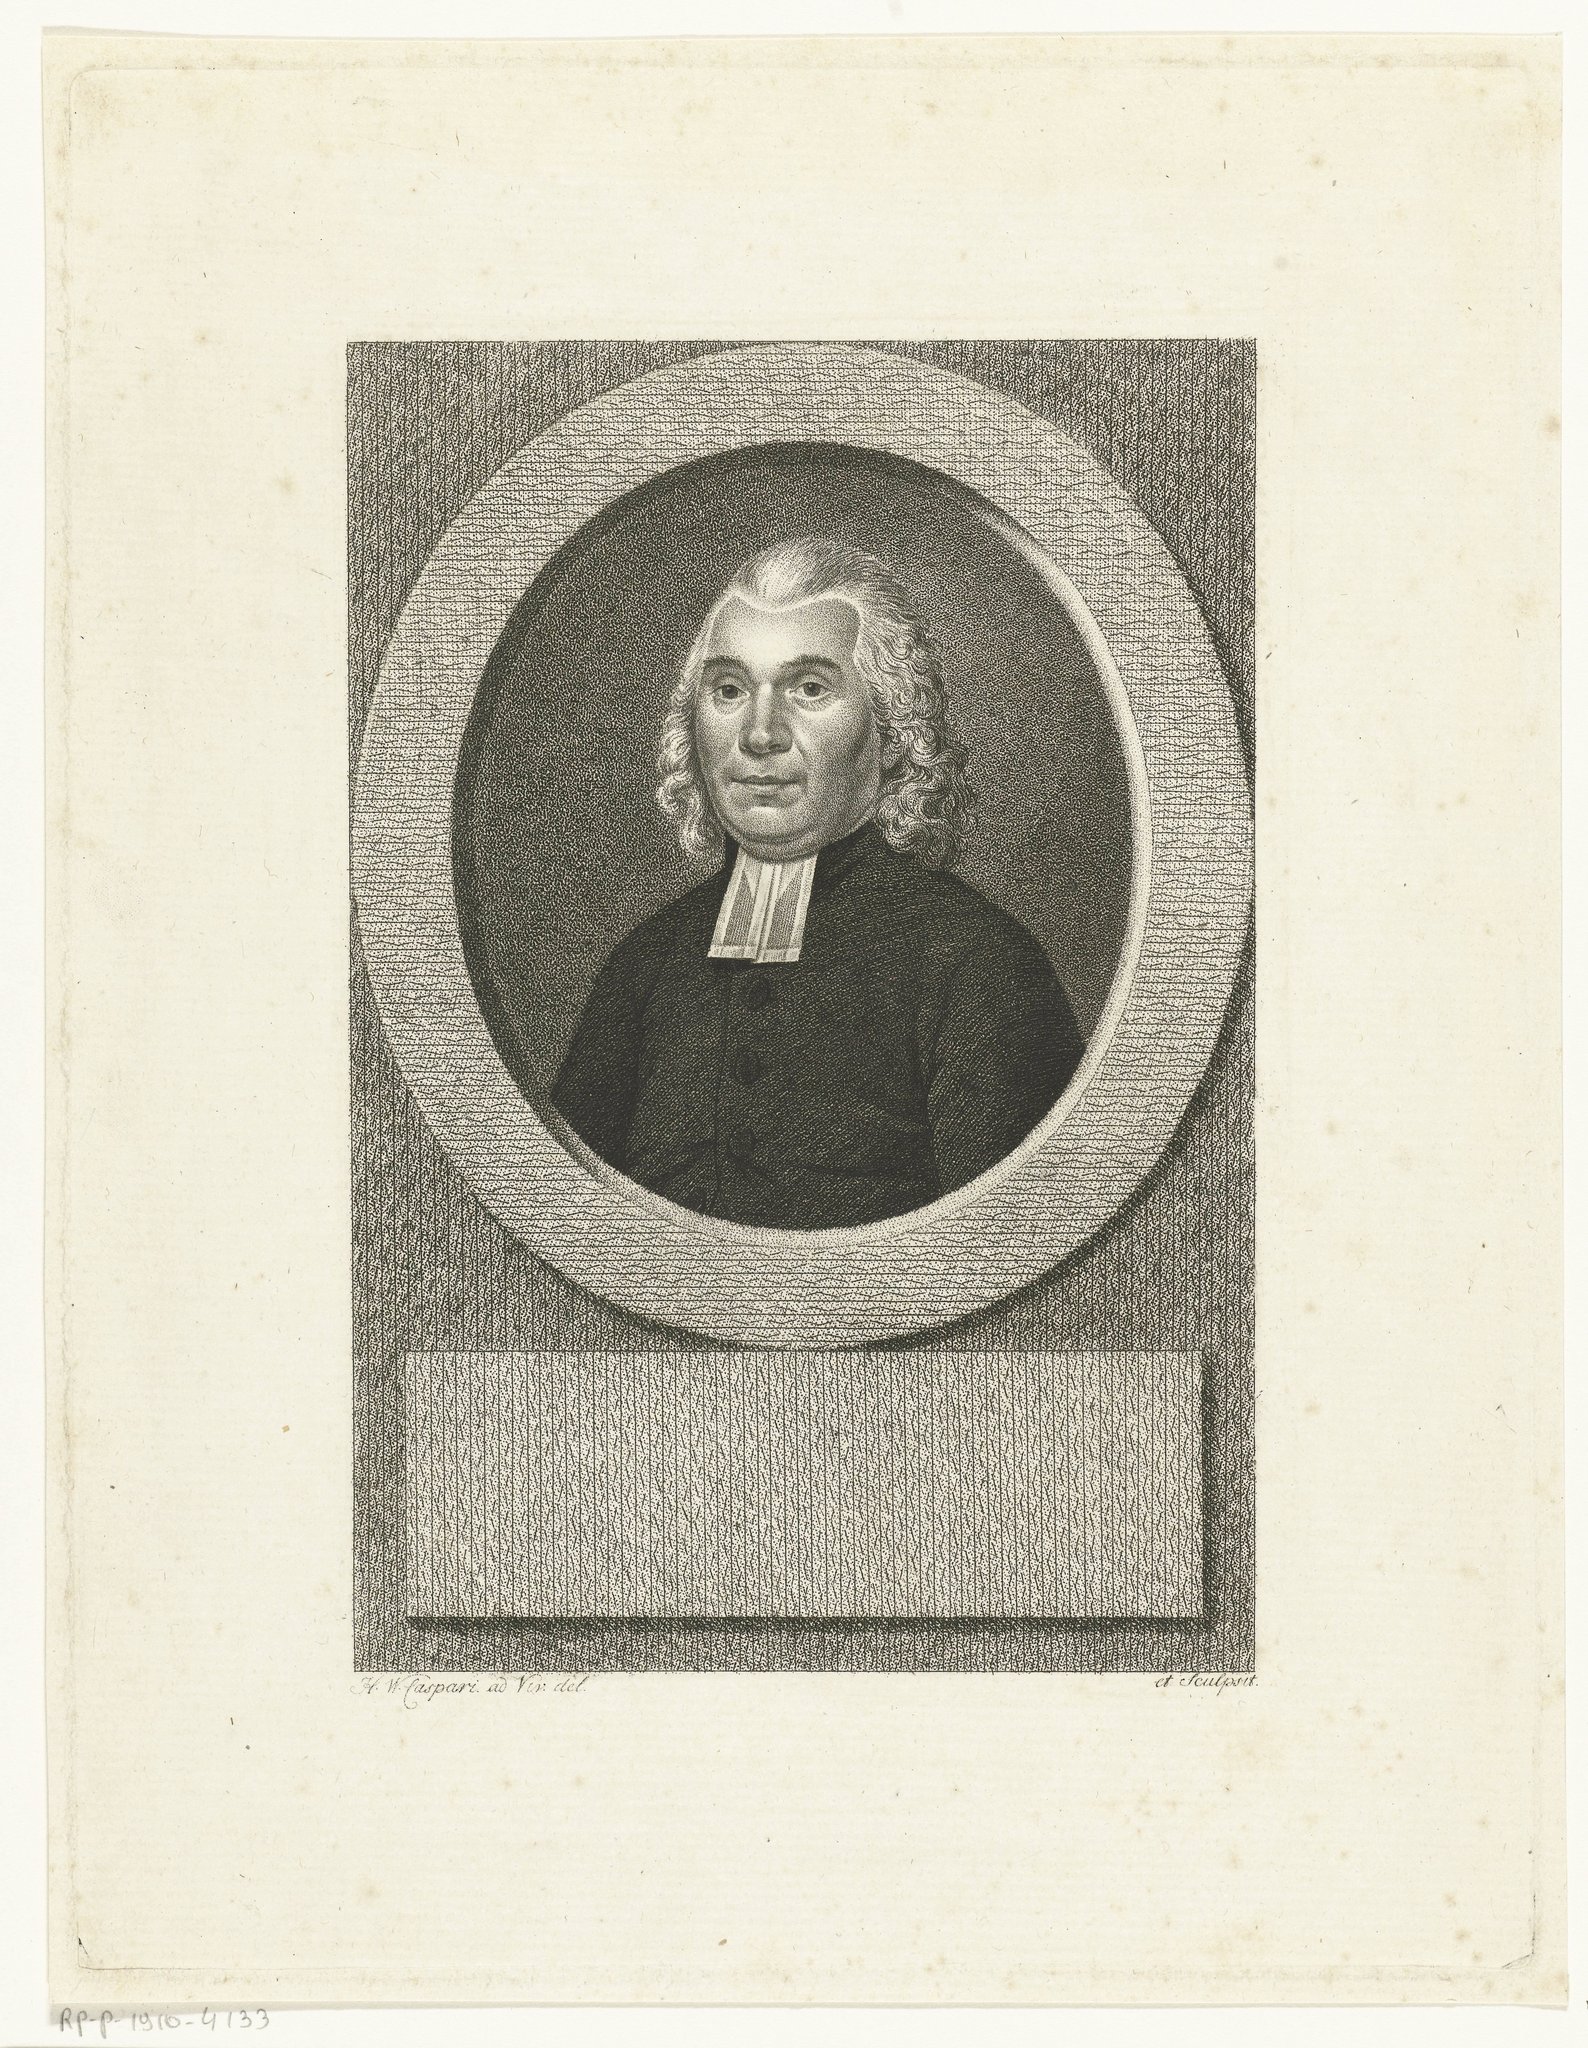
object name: print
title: Uitsnedes van landschappen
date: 1828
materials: paper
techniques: lithograph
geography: paris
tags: landscapes, rural housing, e.g. country-house, villa, cottage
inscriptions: collector's mark: Lugt 2228